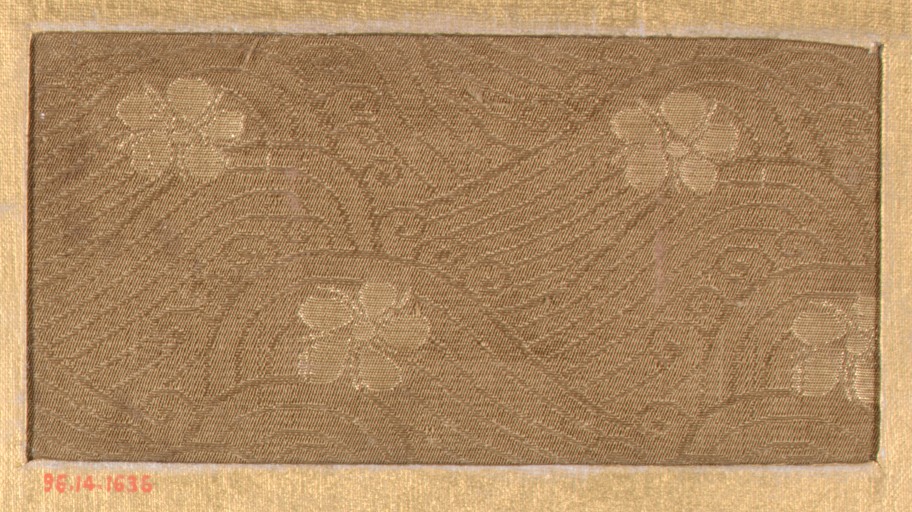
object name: piece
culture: japanese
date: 1701-1900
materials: silk